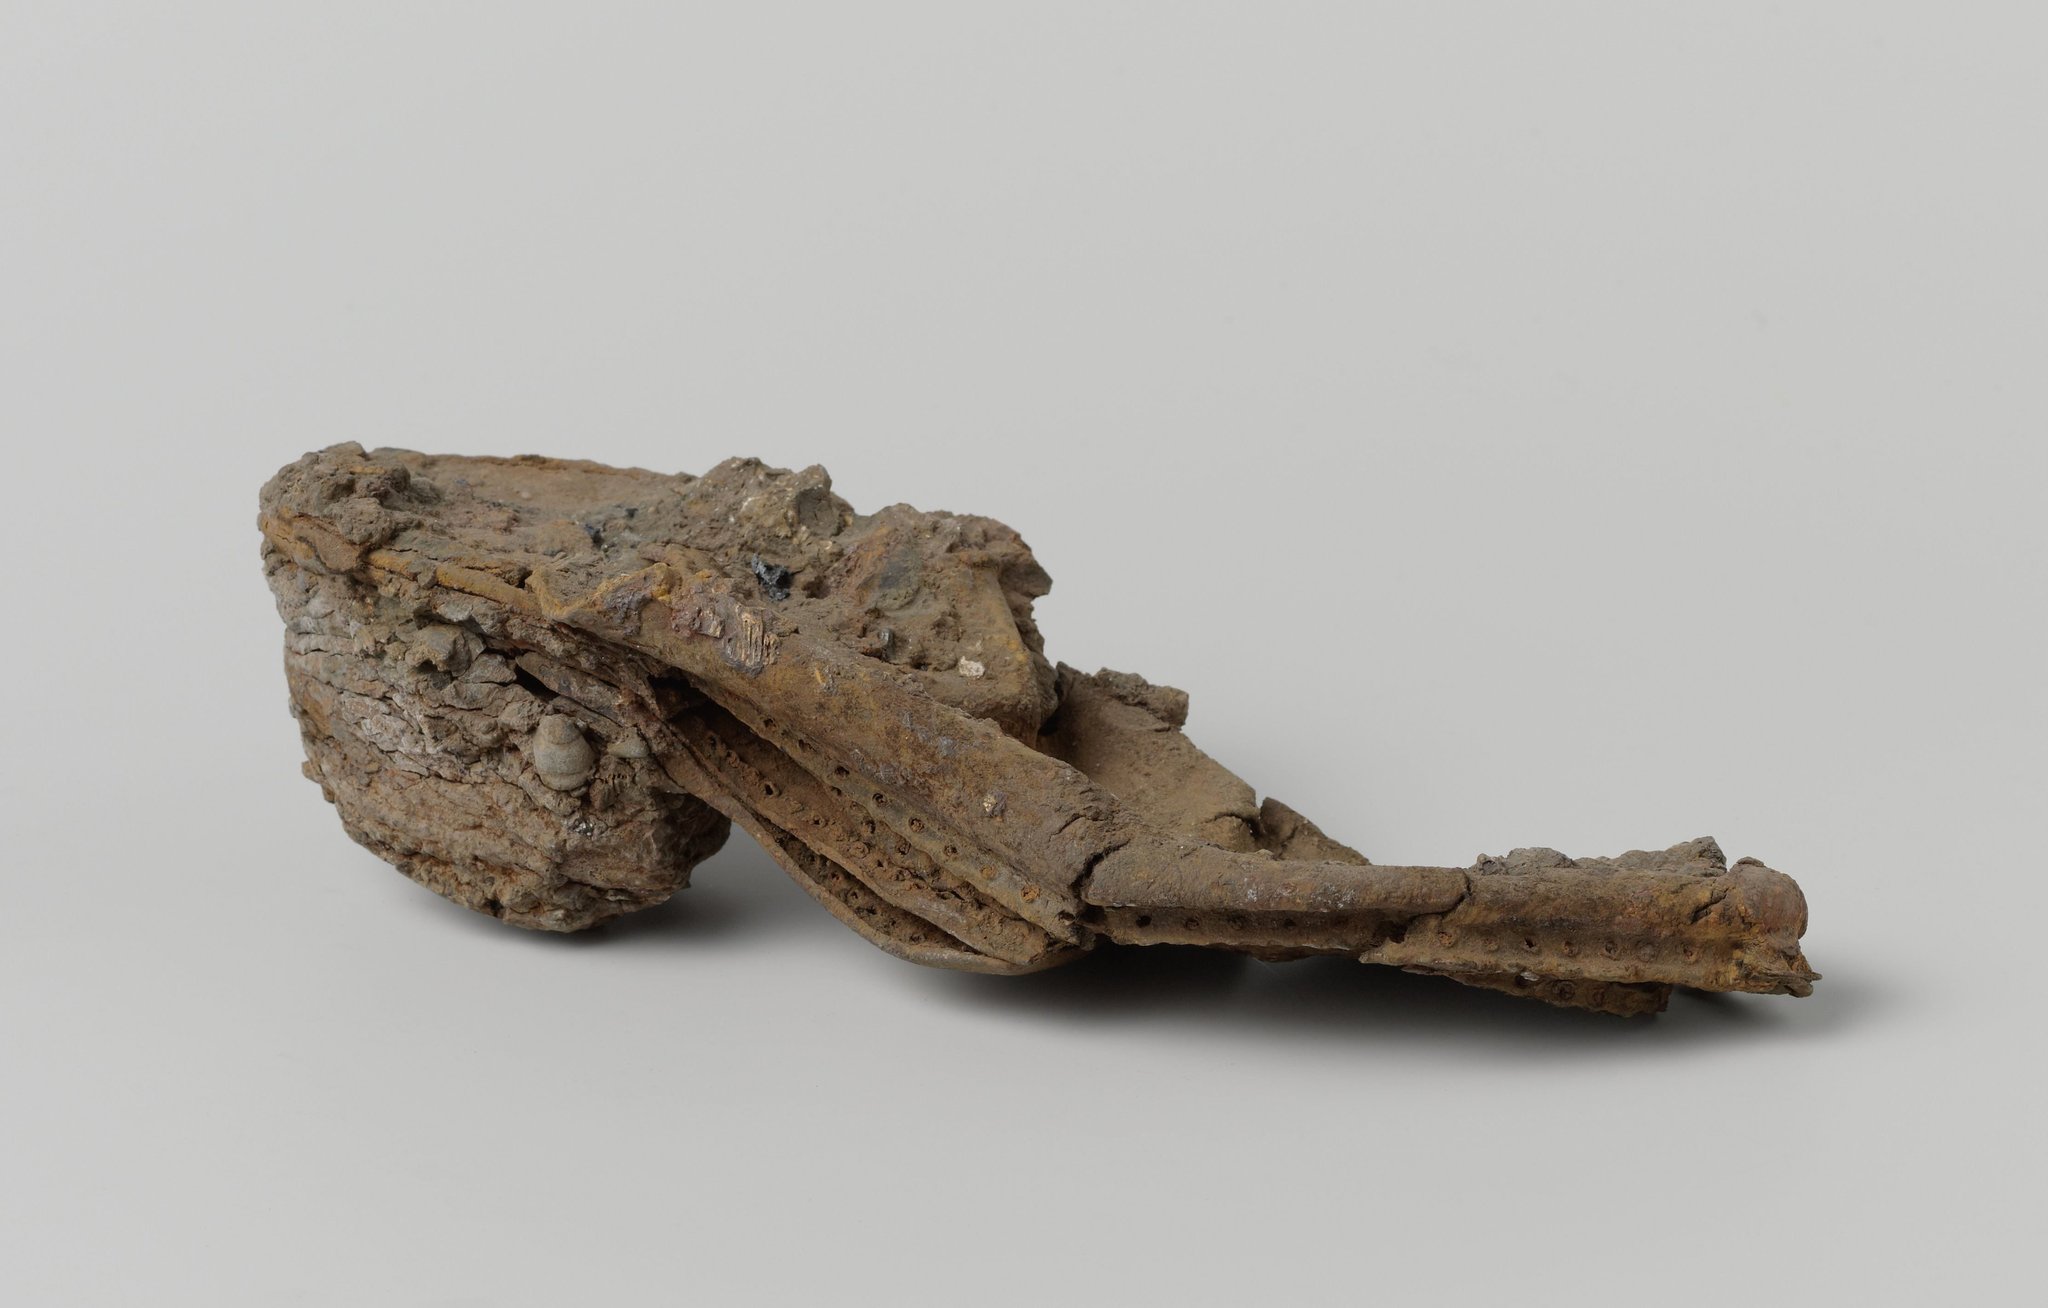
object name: shoe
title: Schoen uit het wrak van de Oost-Indiëvaarder Meresteijn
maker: Anonymous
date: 1700-1702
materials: leather, metal, wood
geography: netherlands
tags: cape of good hope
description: Lederen schoen. Zool opgebouwd uit twee lagen van leer en de hak uit acht of meer lagen. In de hak zijn de spijkers nog zichtbaar, bij de zool de gaten voor het stiksel maar het stiksel zelf niet. Het leer is bedekt met een laag roest of roestige aankoekingen. Shoe.